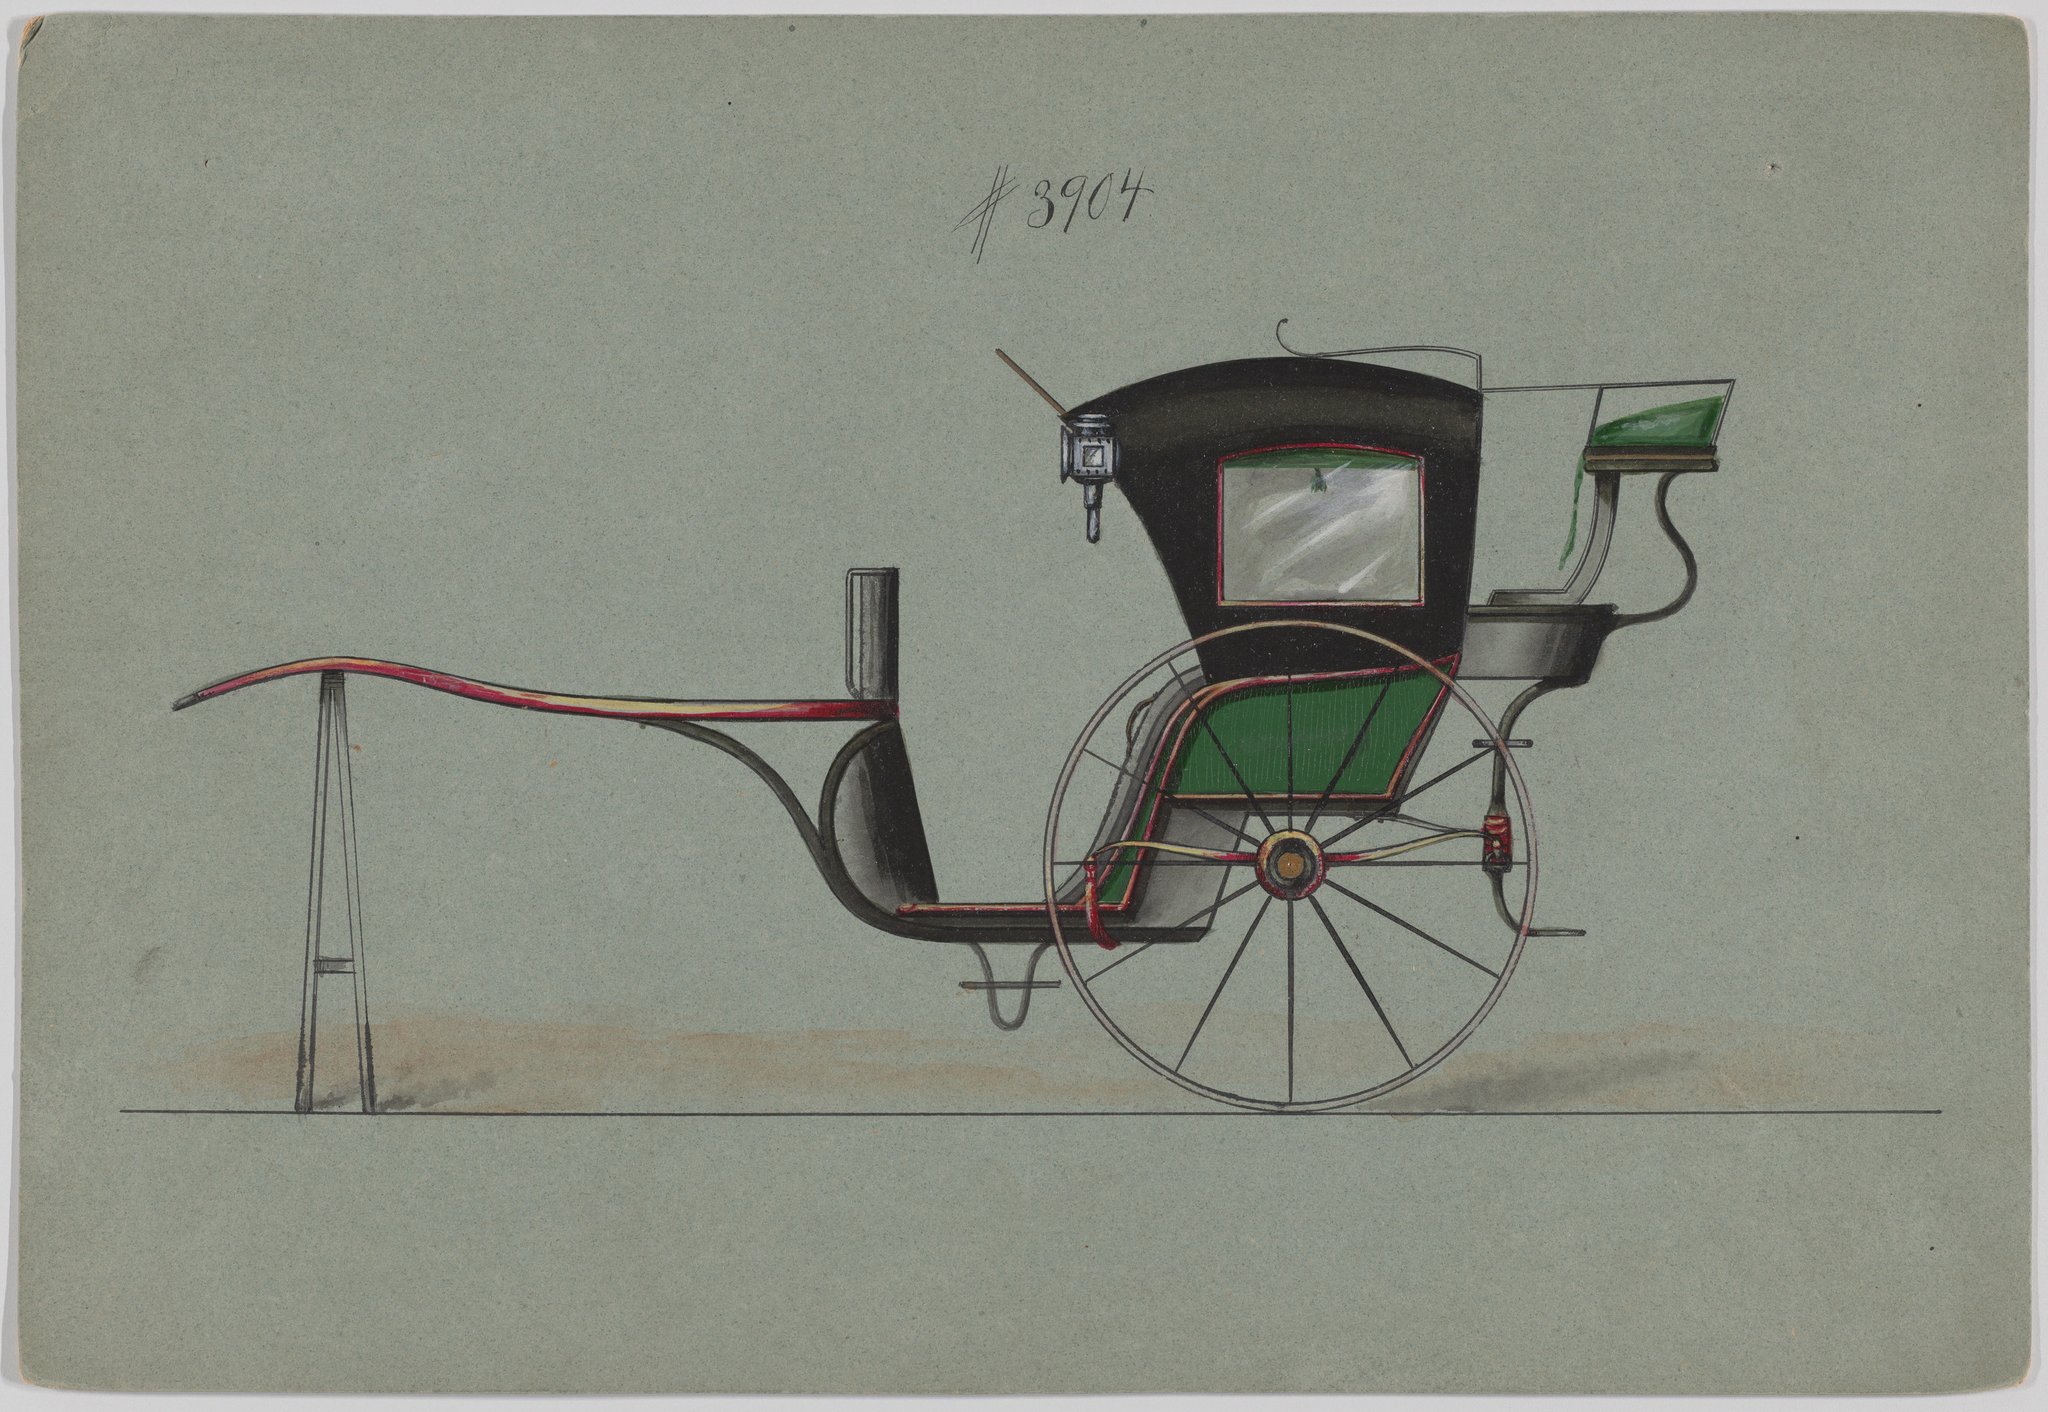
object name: drawing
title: Hansom Cab #3904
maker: brewster & co.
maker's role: manufacturer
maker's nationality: american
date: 1884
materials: gouache, gum arabic, ink, watercolor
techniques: pen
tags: carriages